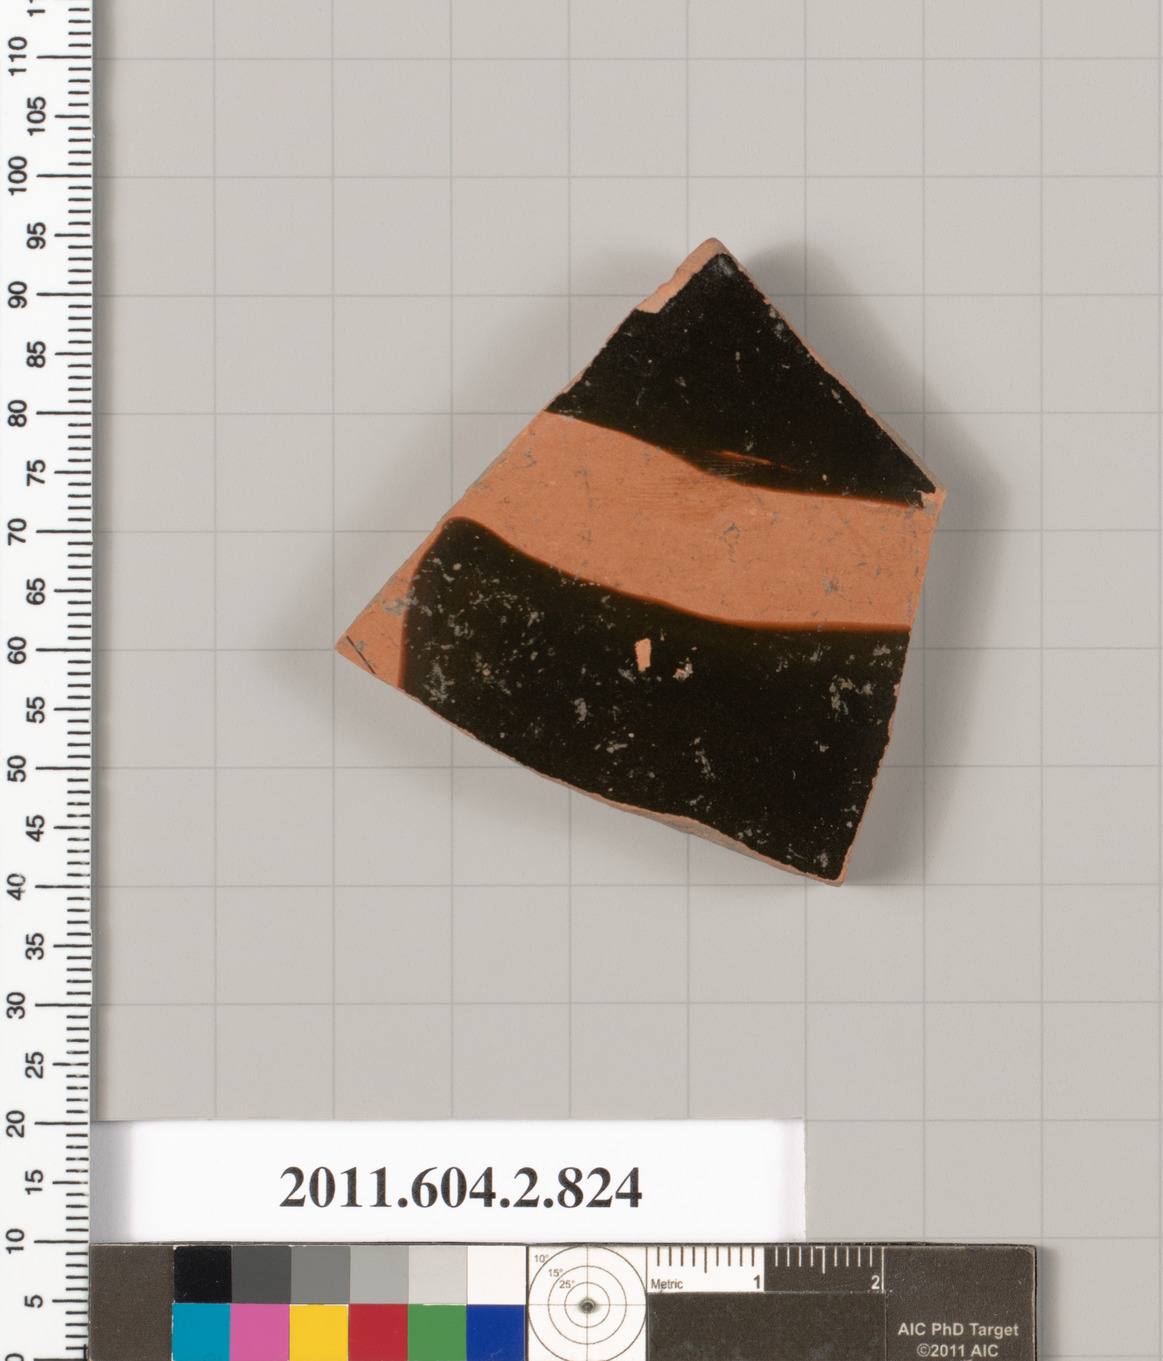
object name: bell krater fragment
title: Terracotta fragment of a bell-krater (bowl for mixing wine and water)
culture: greek, attic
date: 467-435 BCE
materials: terracotta